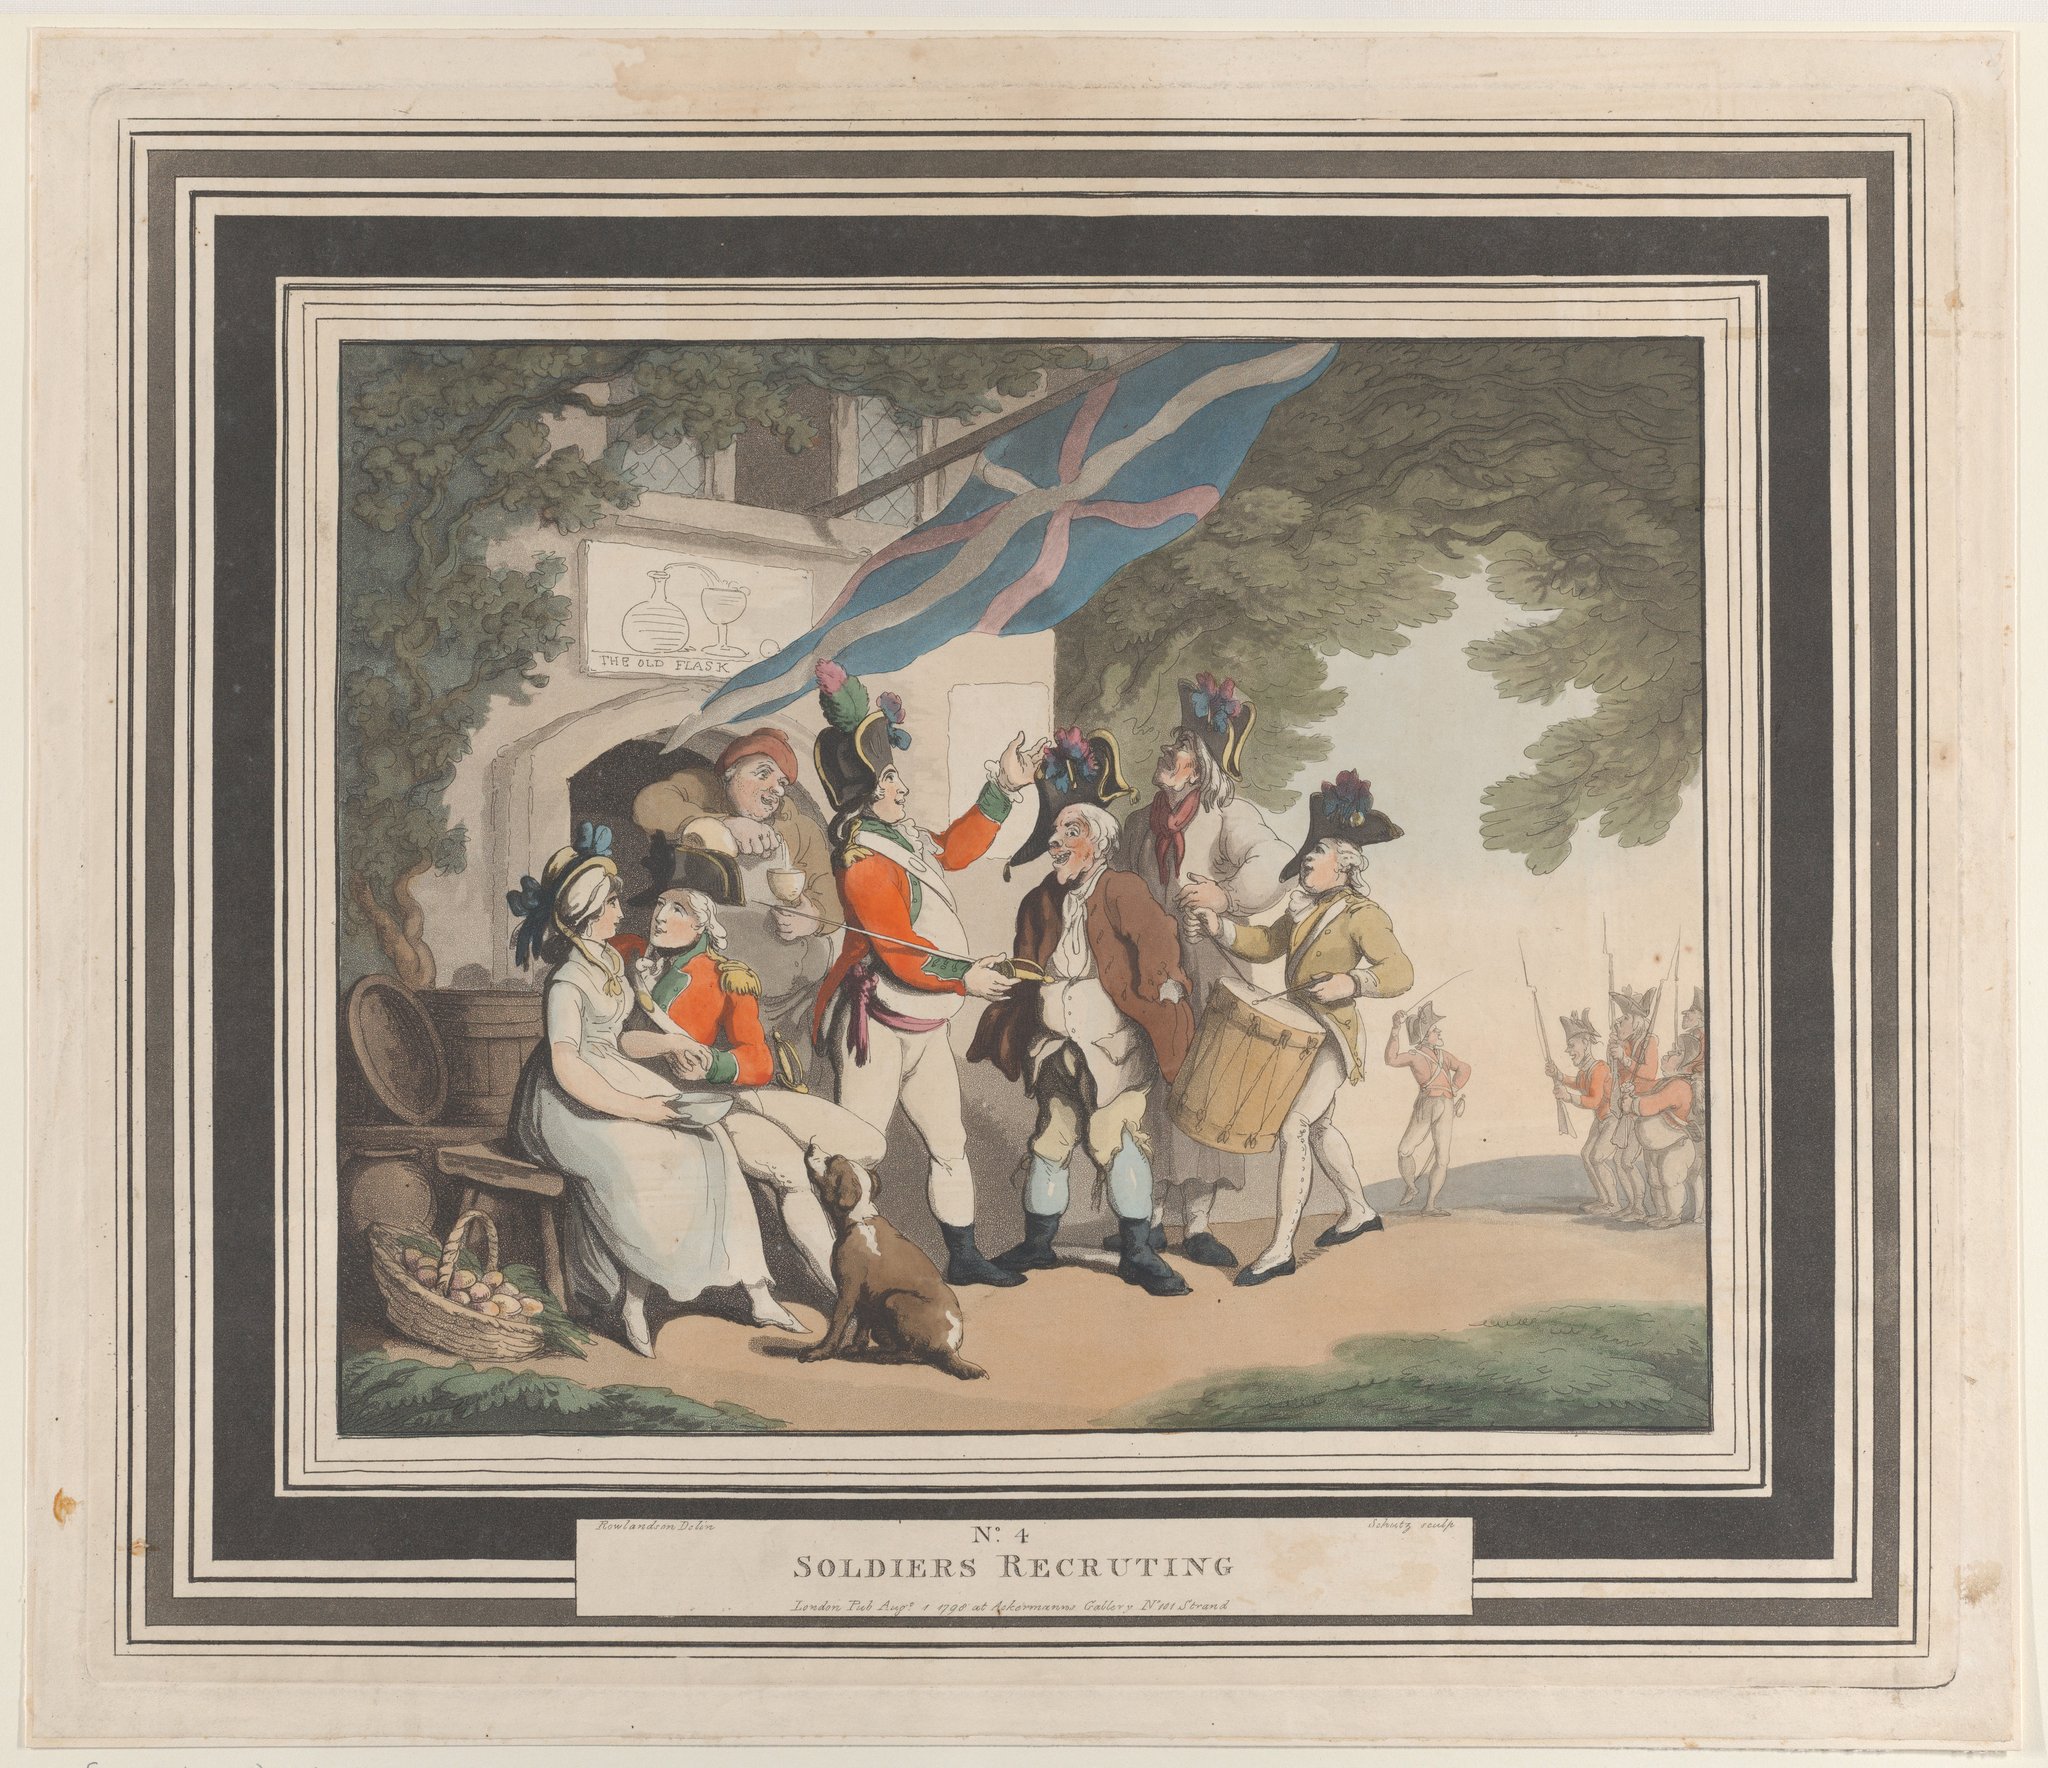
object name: print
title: No. 4: Soldiers Recruiting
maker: heinrich joseph schütz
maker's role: artist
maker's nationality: german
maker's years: 1800-1825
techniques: aquatint, etching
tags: soldiers,men,women,dogs